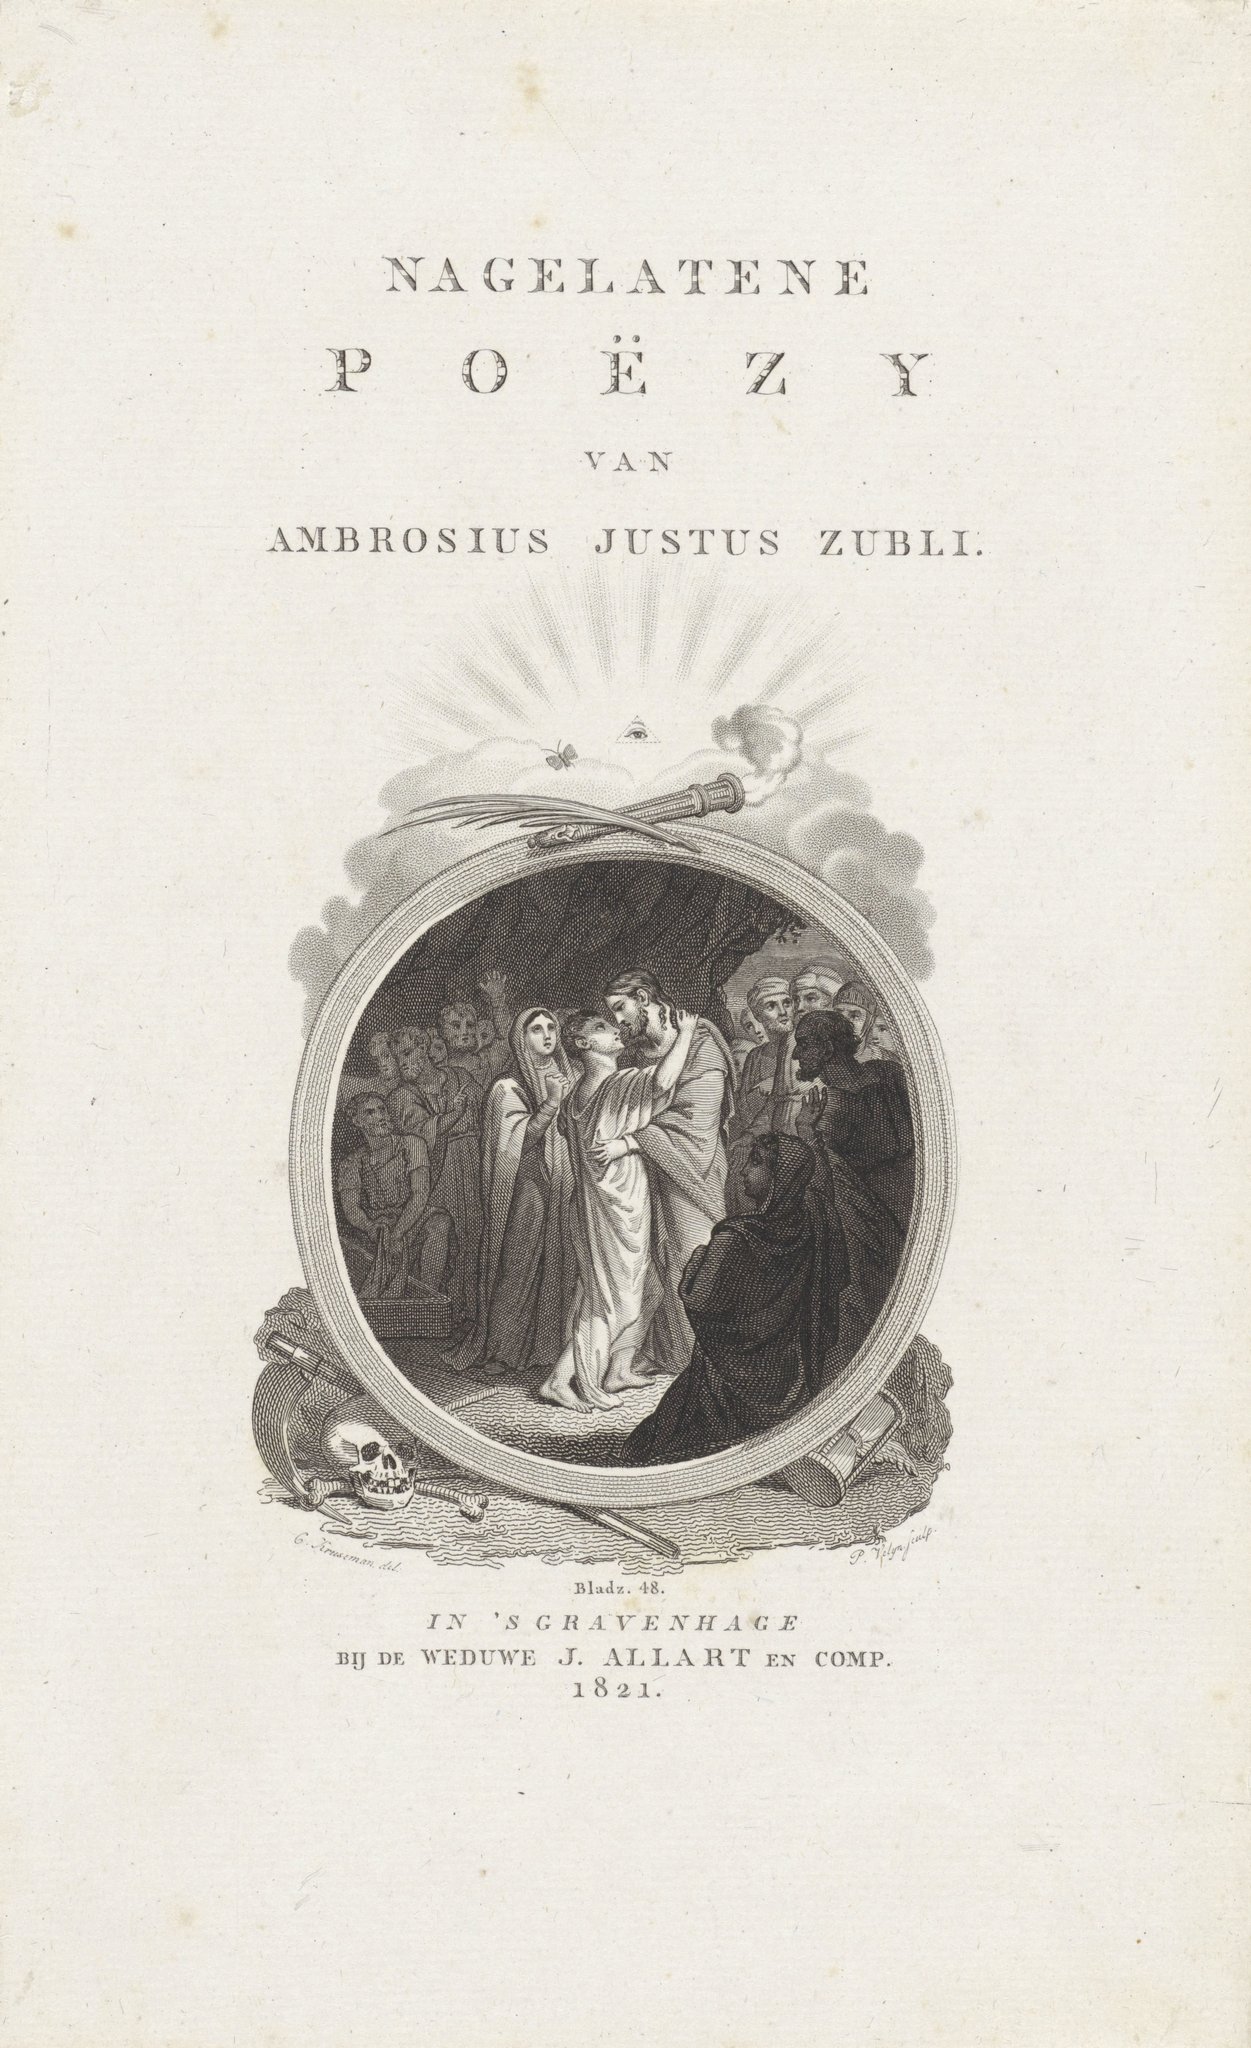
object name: titelblad, titelpagina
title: Judas kust Christus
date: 1821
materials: paper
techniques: engraving, etching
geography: the hague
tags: the kiss of judas: accompanied by soldiers with torches and lanterns, he kisses christ (+ variant), skull as symbol of 'vanitas', the all-seeing eye, triangle with eye ~ symbol of god the father, death's head, skull (symbol of death)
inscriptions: collector's mark: Lugt 2228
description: Tussen vele toekijkende figuren kust Judas Christus. Boven de afbeelding een gedoofde fakkel, een palmtak en een vlinder, waarboven het Alziend Oog met een stralen omringd. Onder het medaillon met de afbeelding een gevleugelde zandloper, een zeis en een schedel.